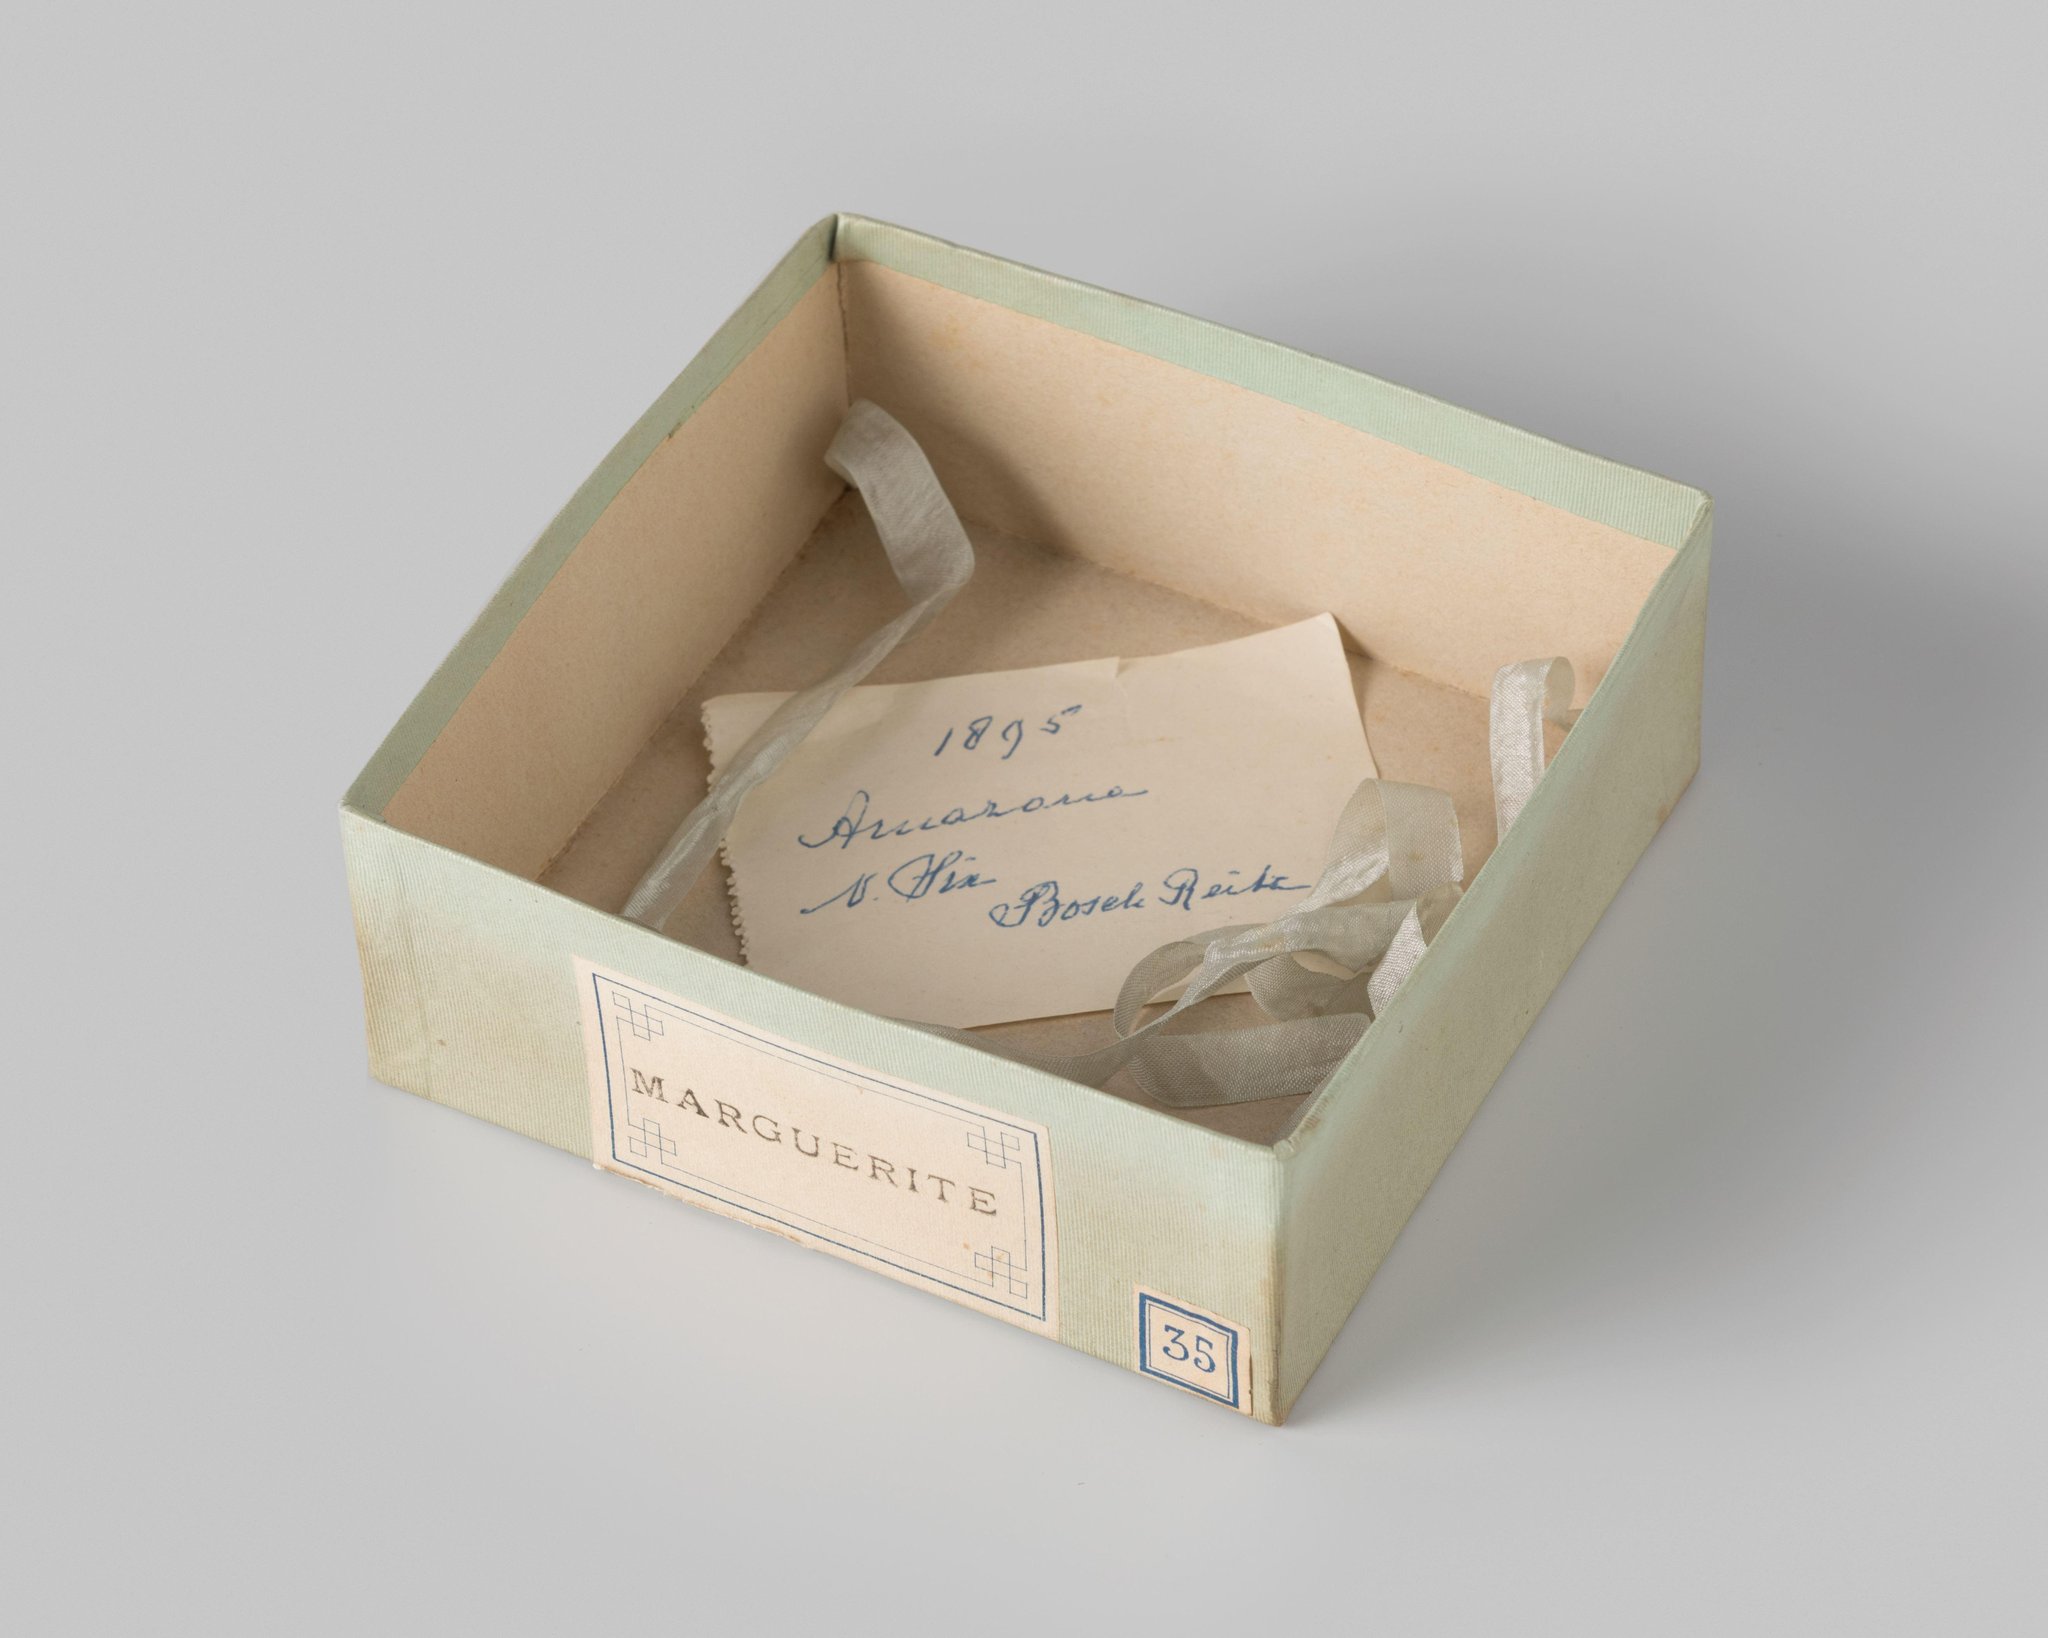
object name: box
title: Doos behorend bij een aantal boorden van een kostuum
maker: Anonymous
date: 1895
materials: cardboard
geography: france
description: Doos van turquoise moiré-papier met adres MARGUERITE 35.